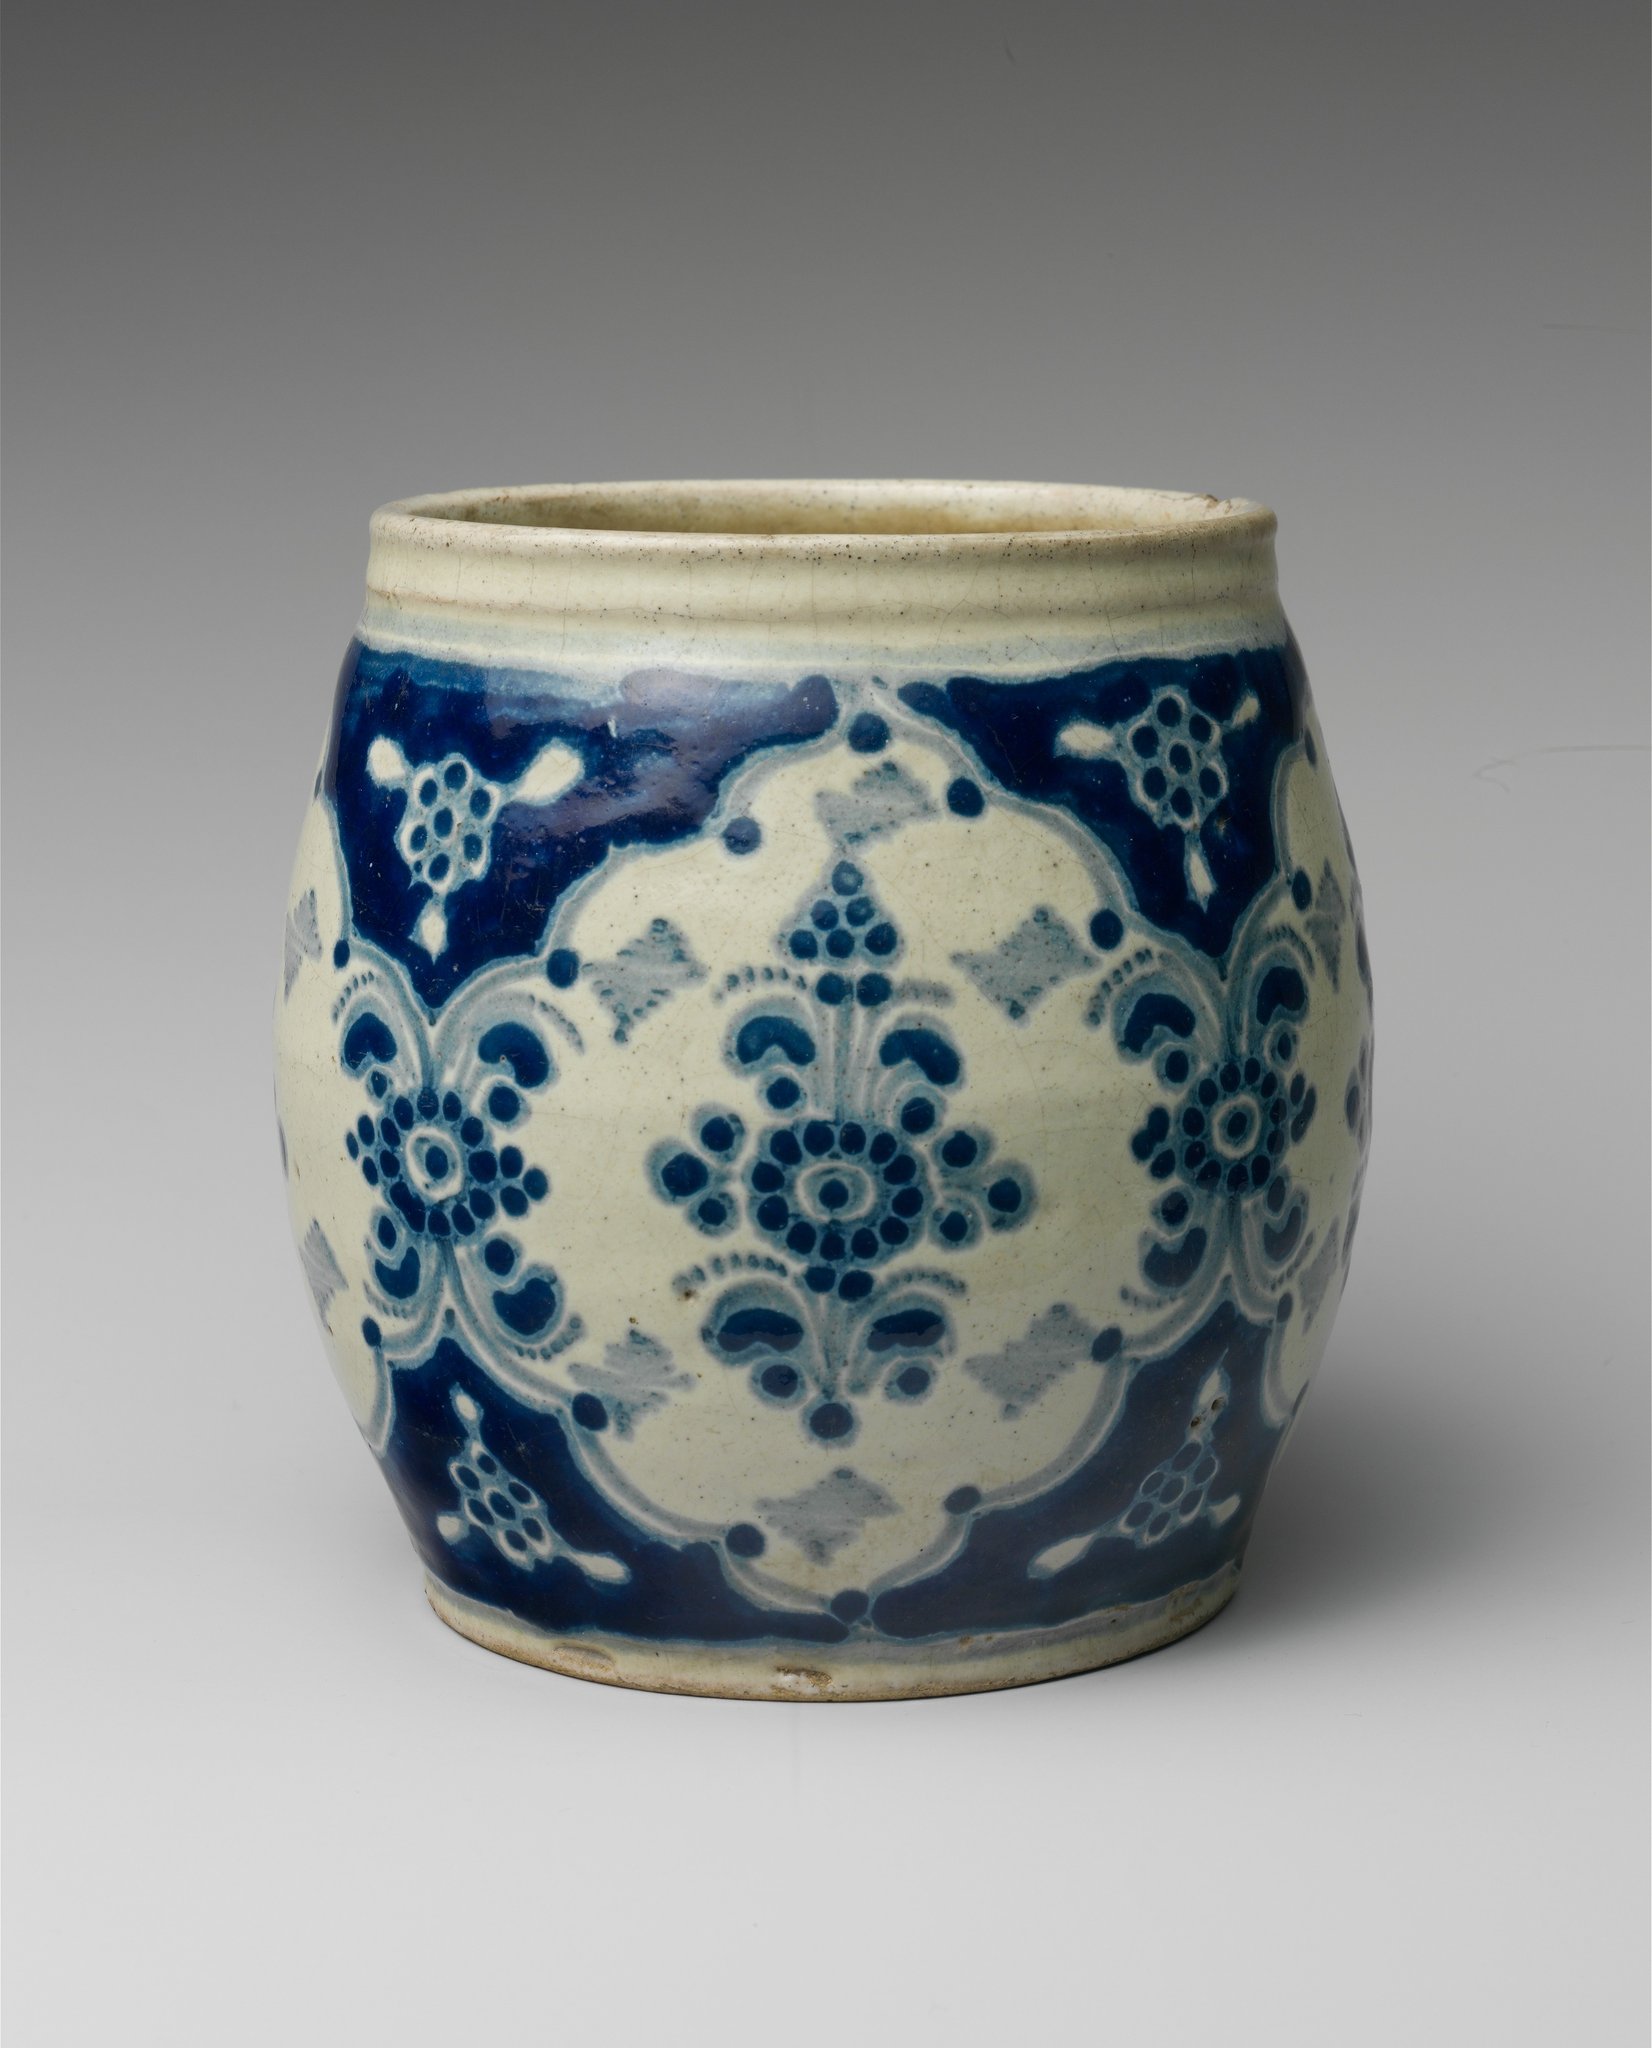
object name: flower pot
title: Barrel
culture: mexican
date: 1750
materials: earthenware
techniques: glazing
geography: mexico